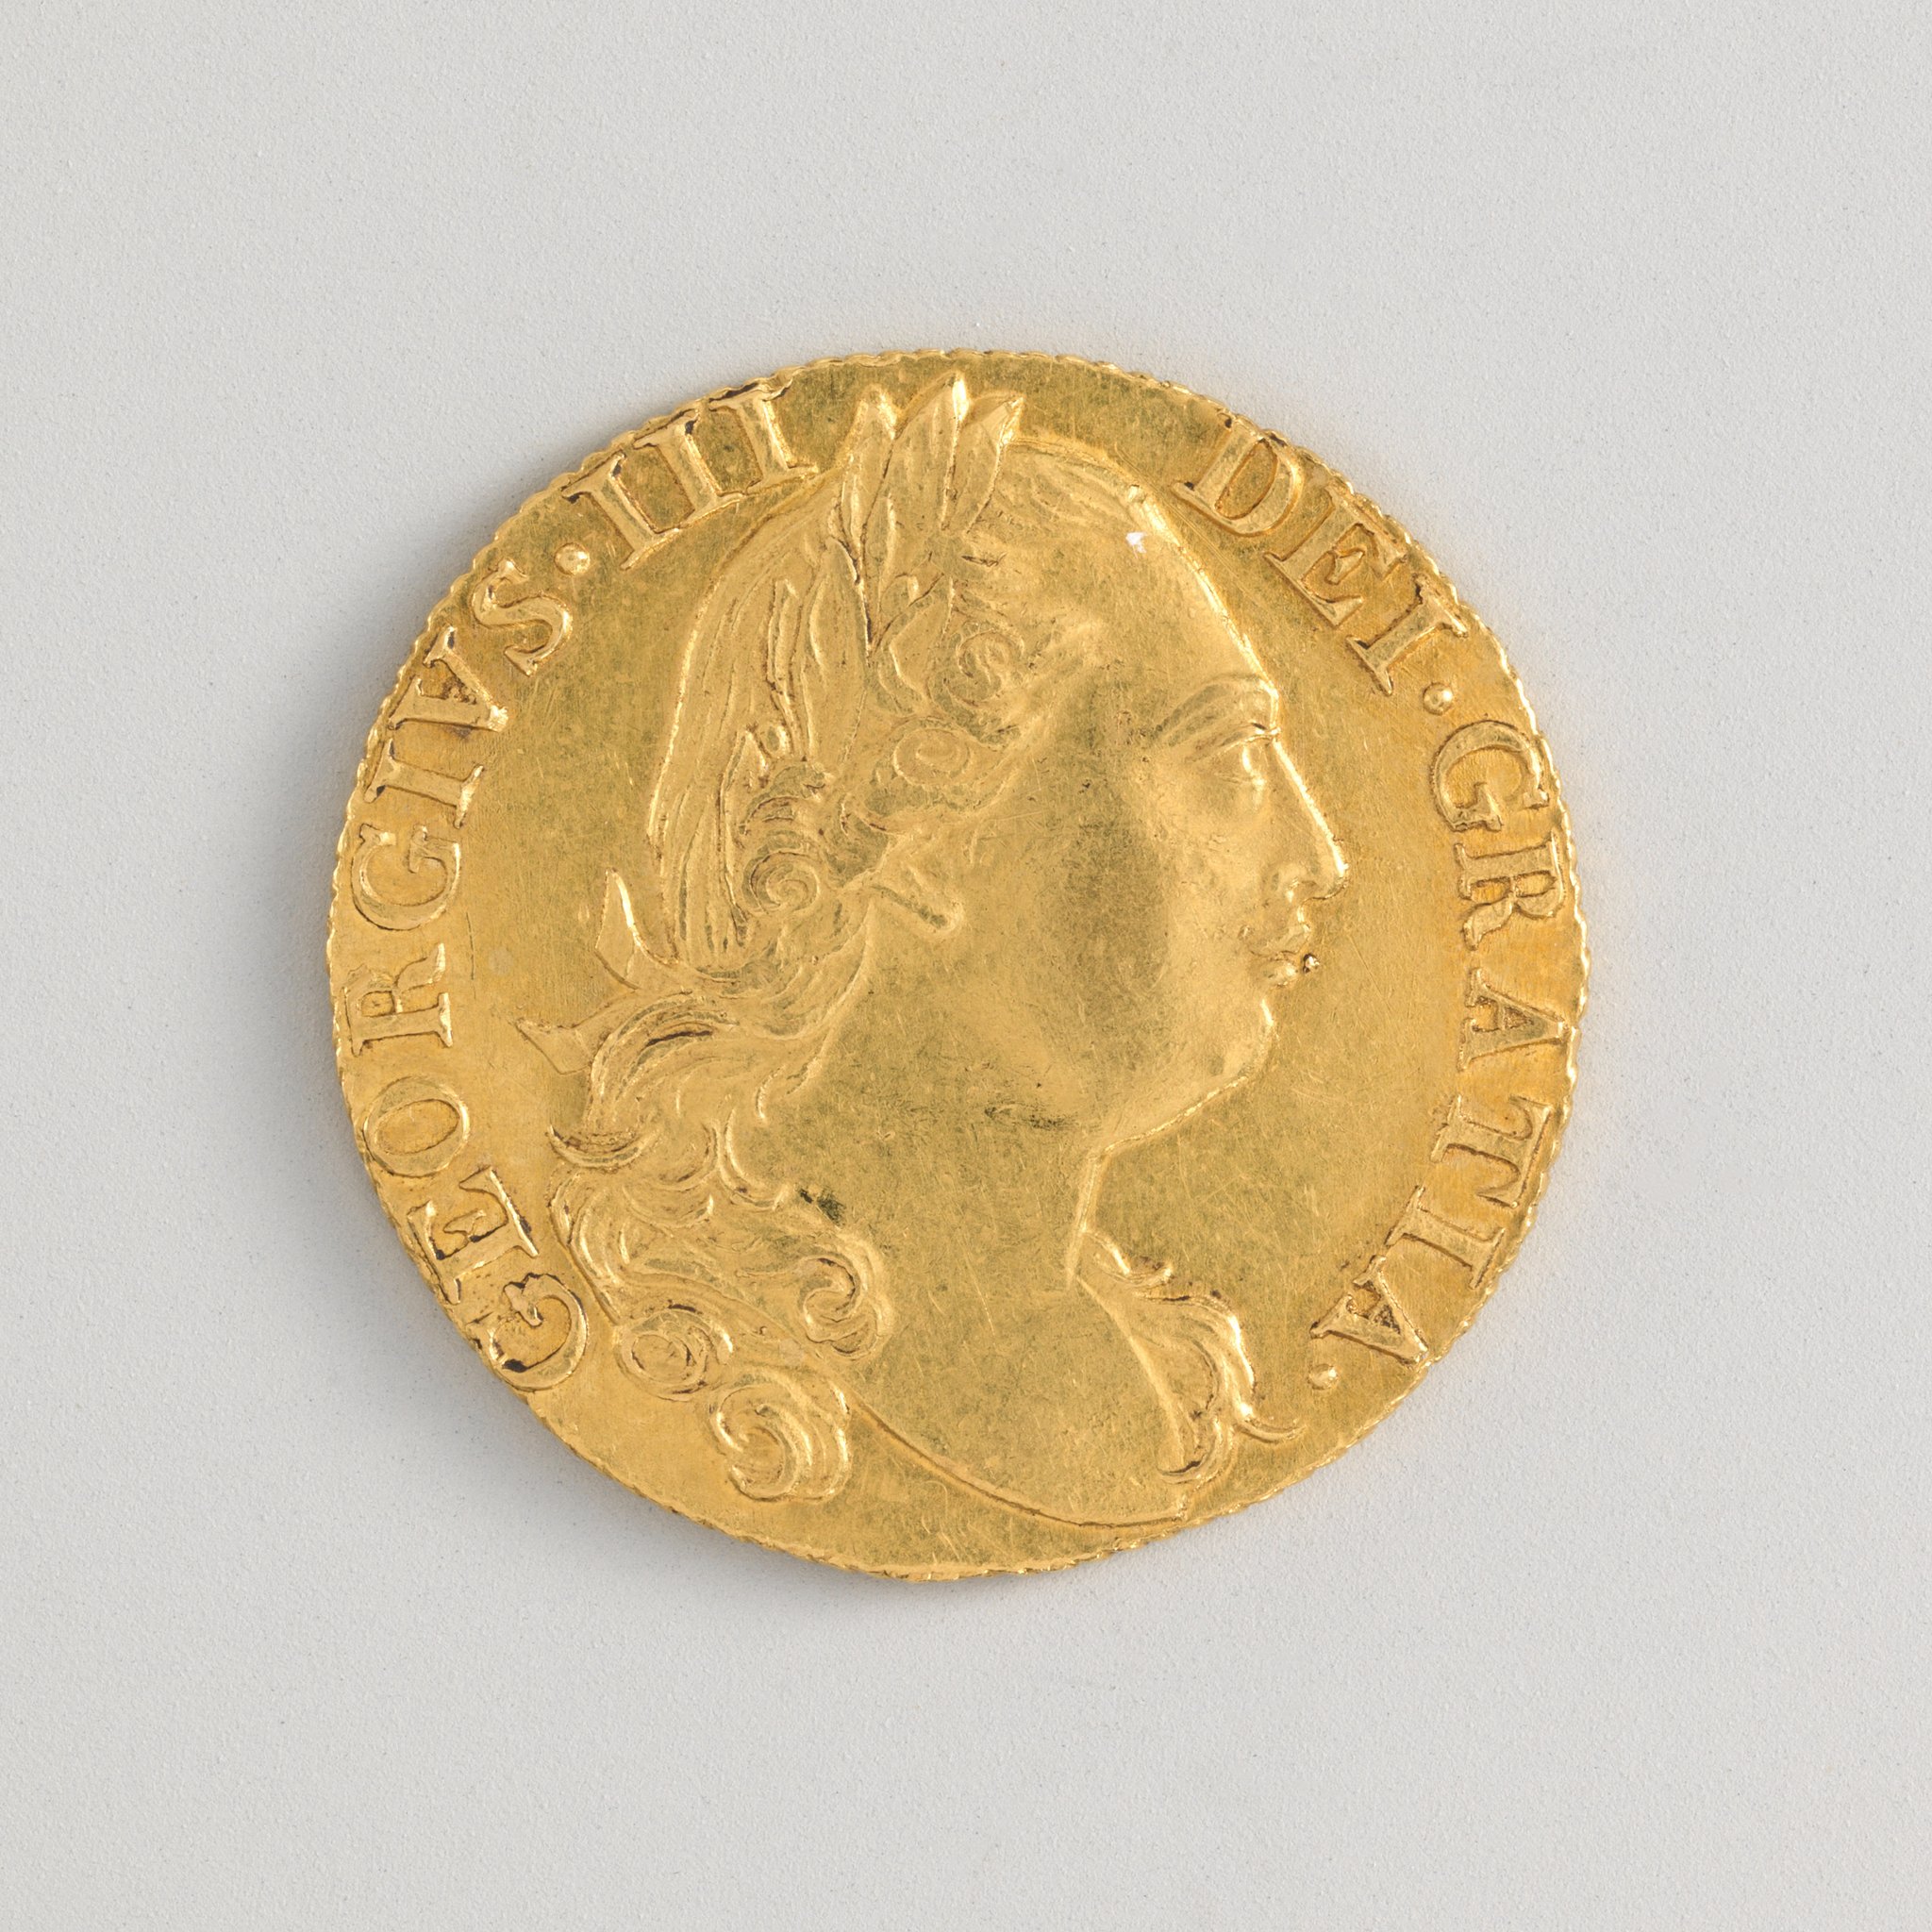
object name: guinea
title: George III guinea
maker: thomas pingo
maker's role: artist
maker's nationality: italian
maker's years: 1692-1776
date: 1777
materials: gold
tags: kings,profiles,coins